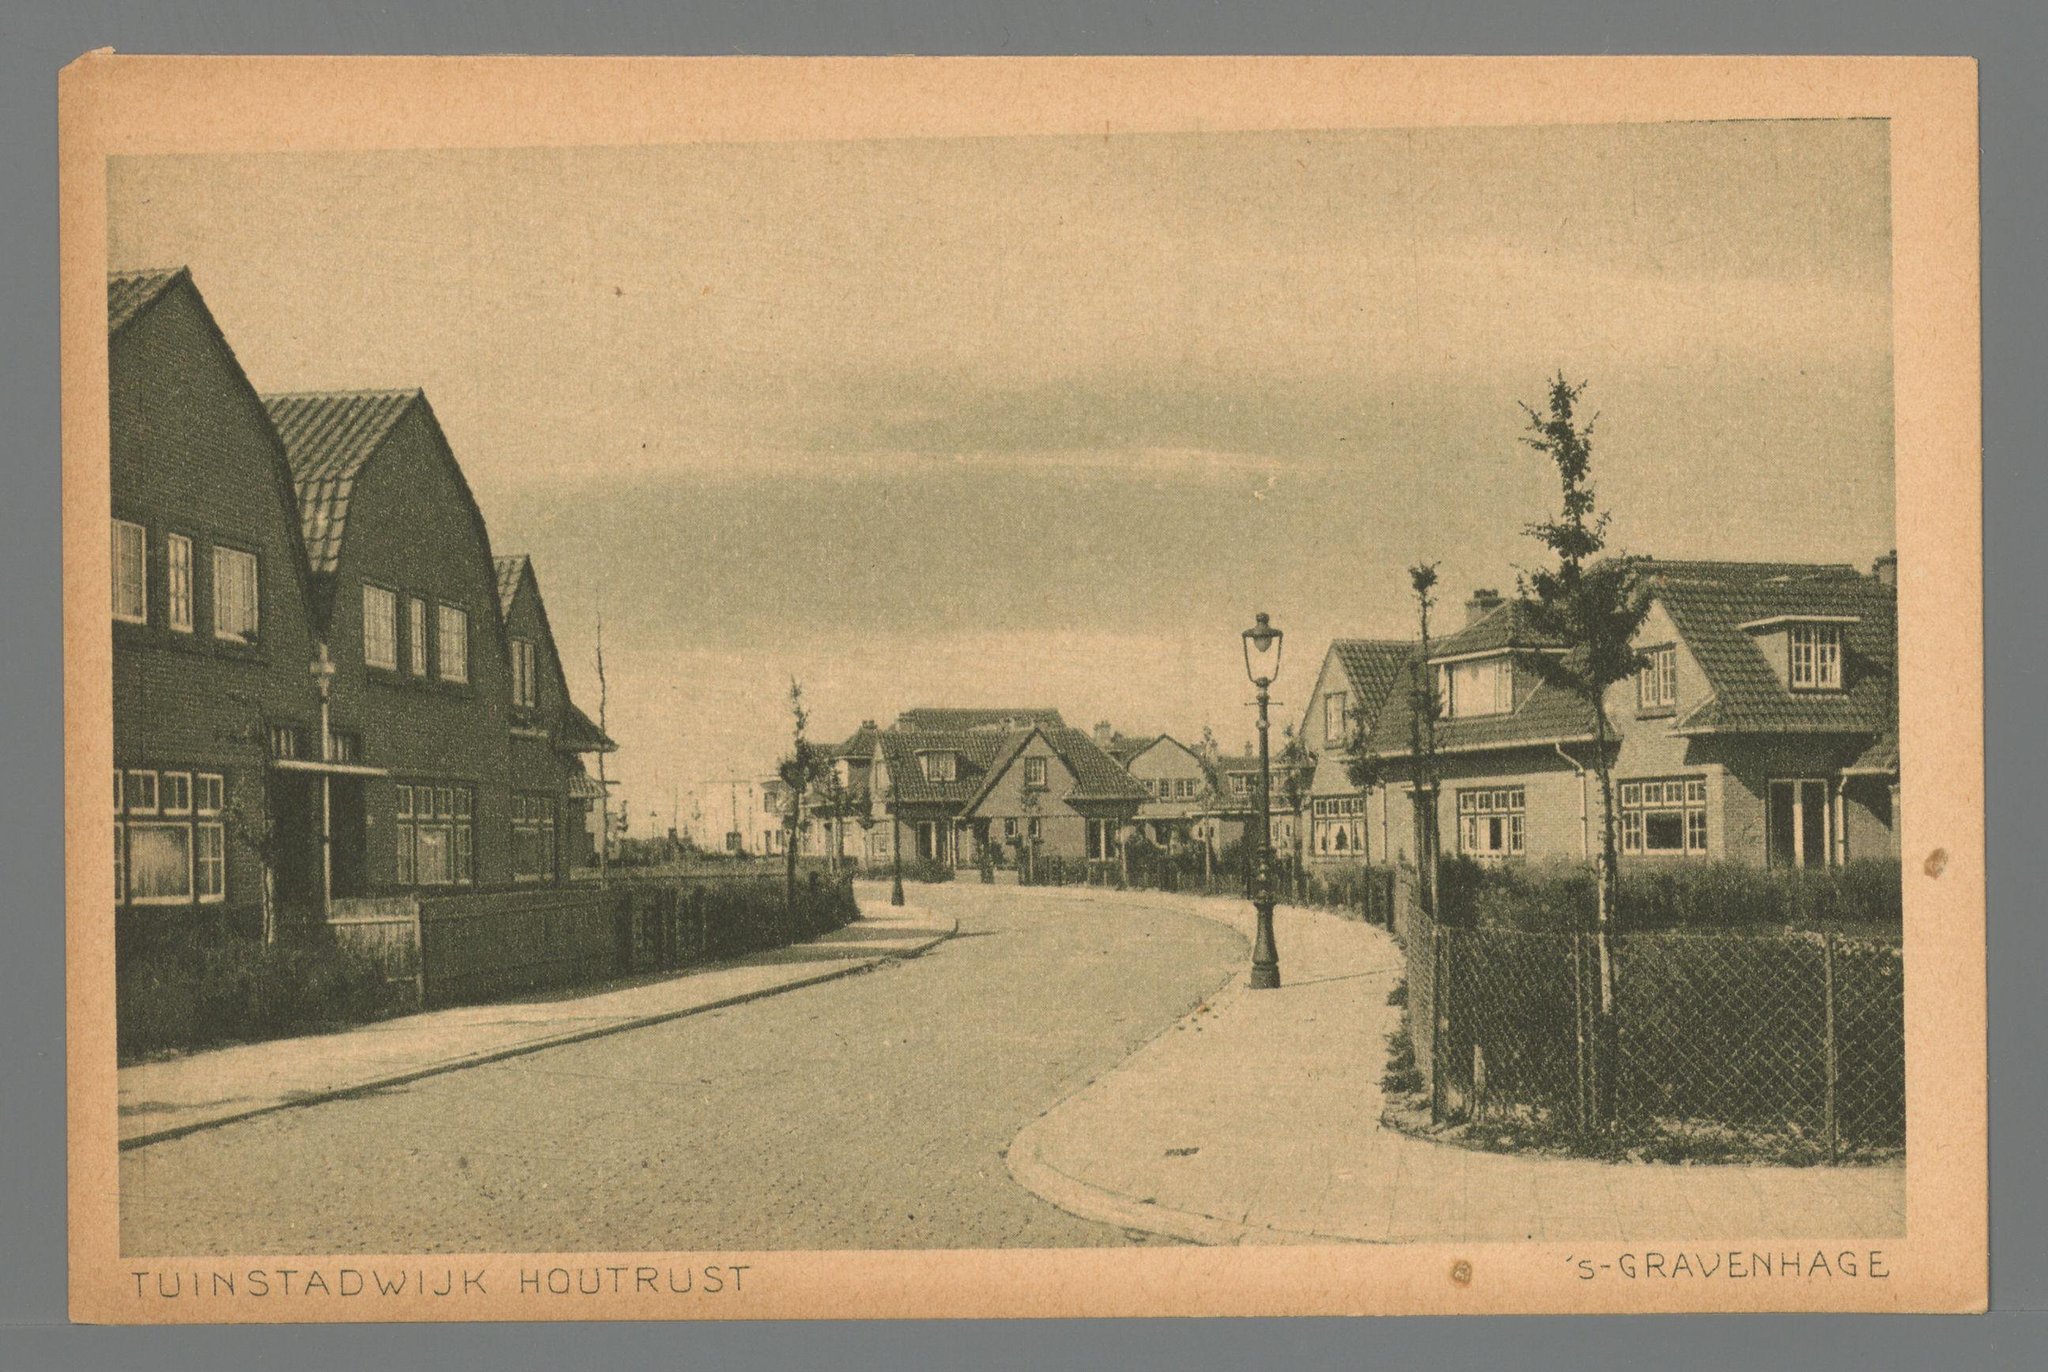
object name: ansichtkaart, prentbriefkaart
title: Tuinstadwijk Houtrust. 's-Gravenhage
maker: johannes gerardus happel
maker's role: publisher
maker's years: 1854-1928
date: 1913-1928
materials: cardboard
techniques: rotogravure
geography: the hague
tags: street